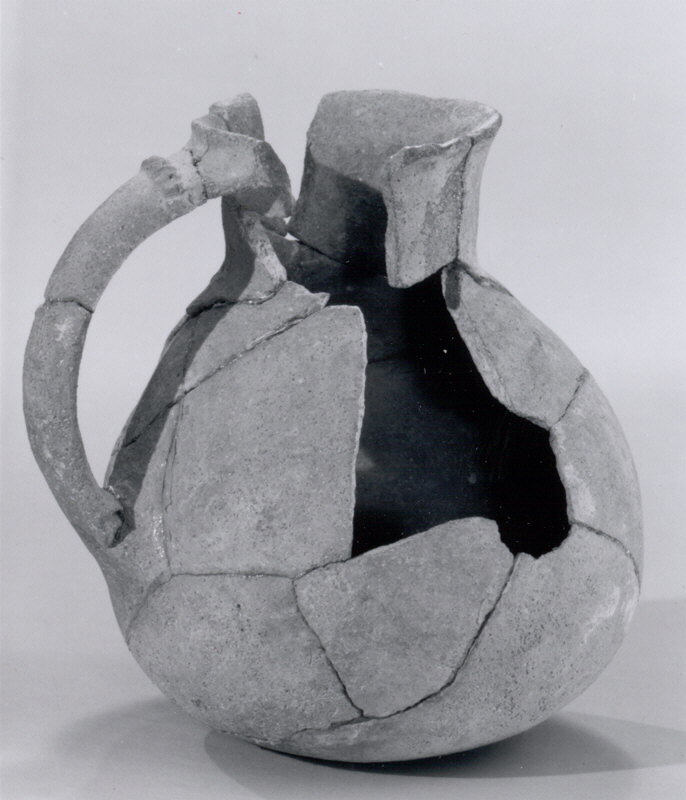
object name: jar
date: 3500-3300 BCE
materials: ceramic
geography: levant